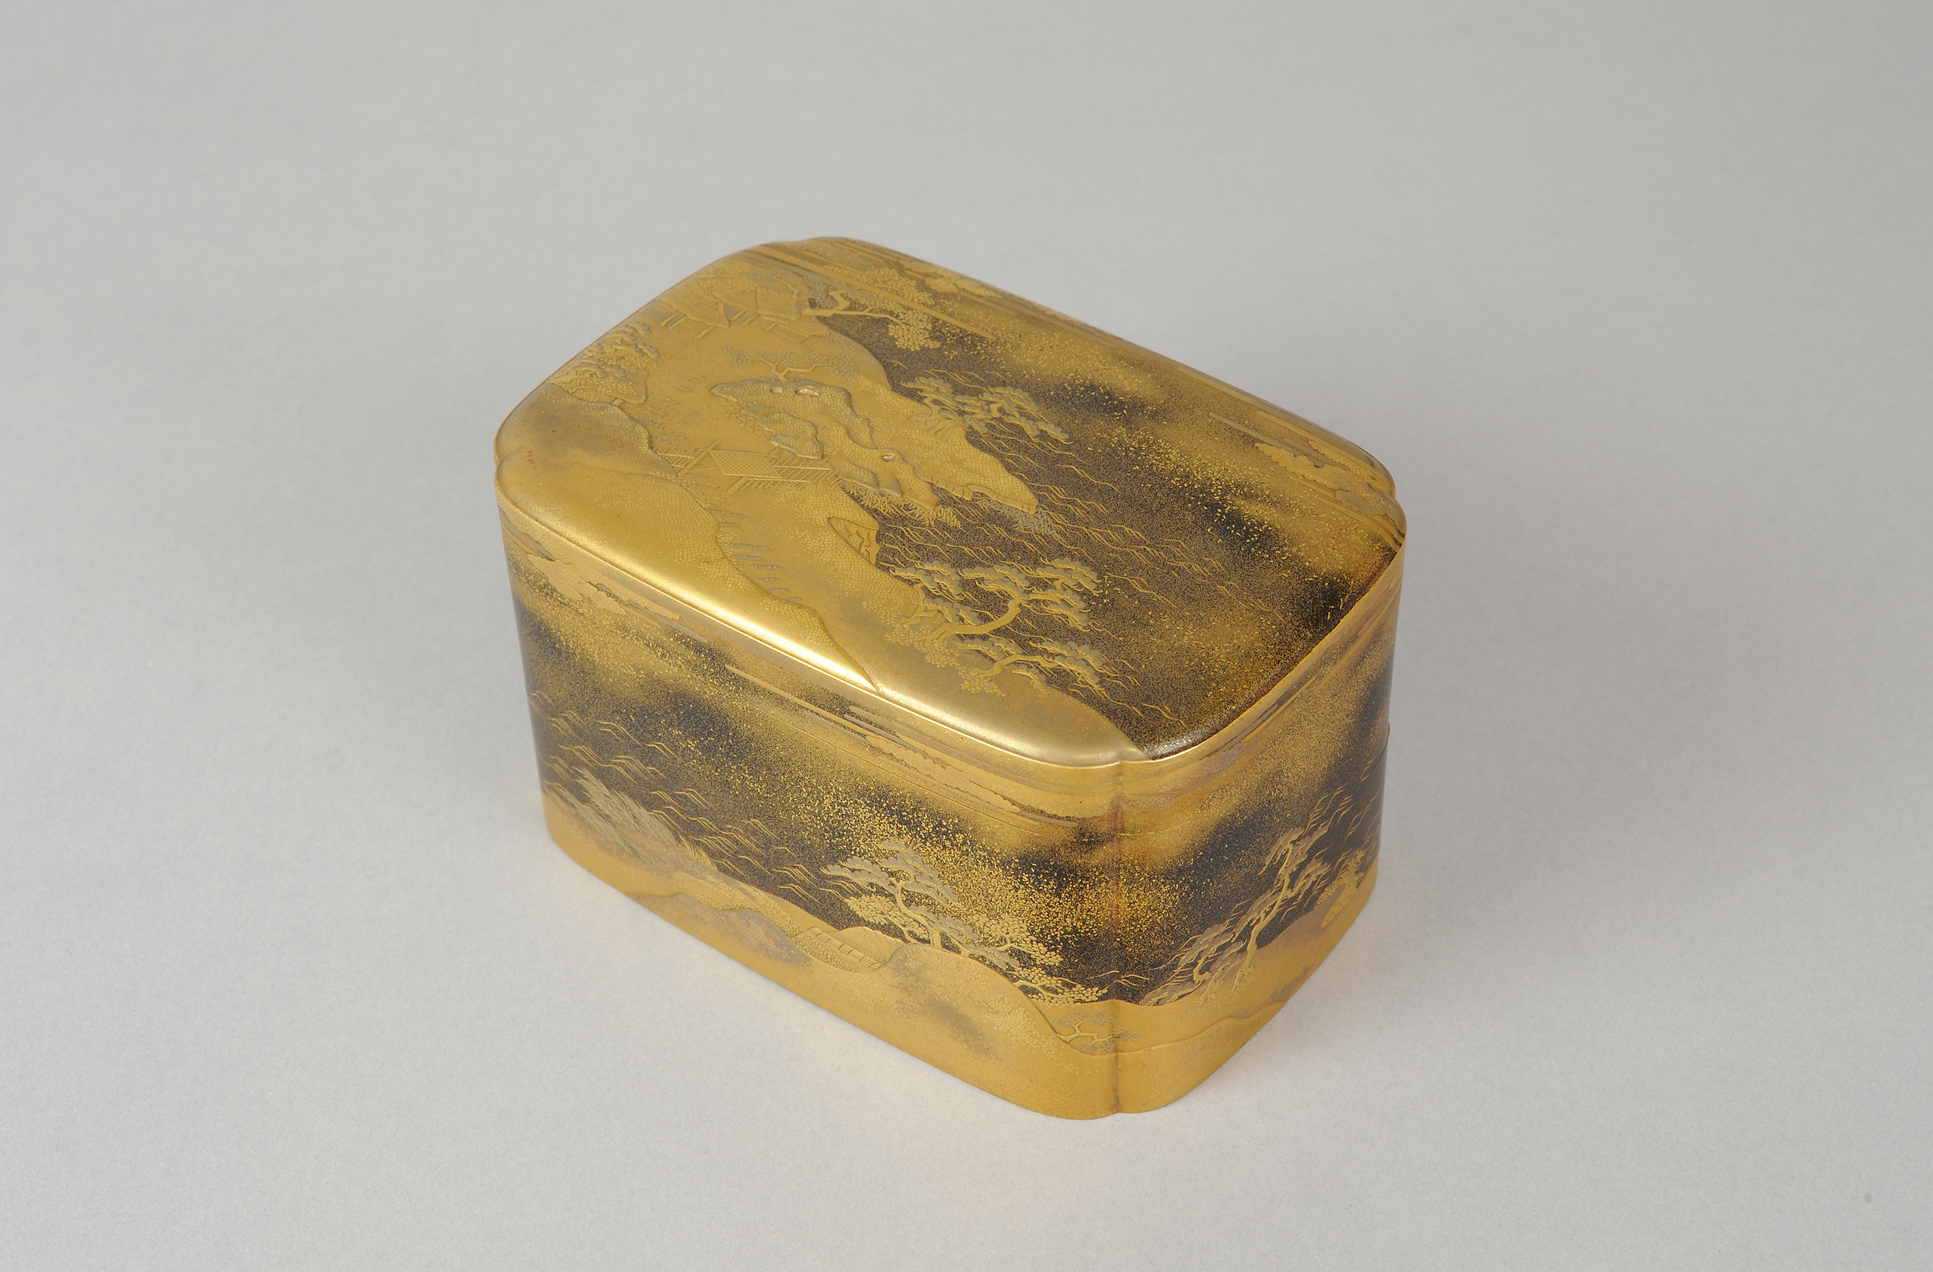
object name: box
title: Box with Design of Pines Along the Shore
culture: japanese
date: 1867-1900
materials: gold, lacquer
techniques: maki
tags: trees